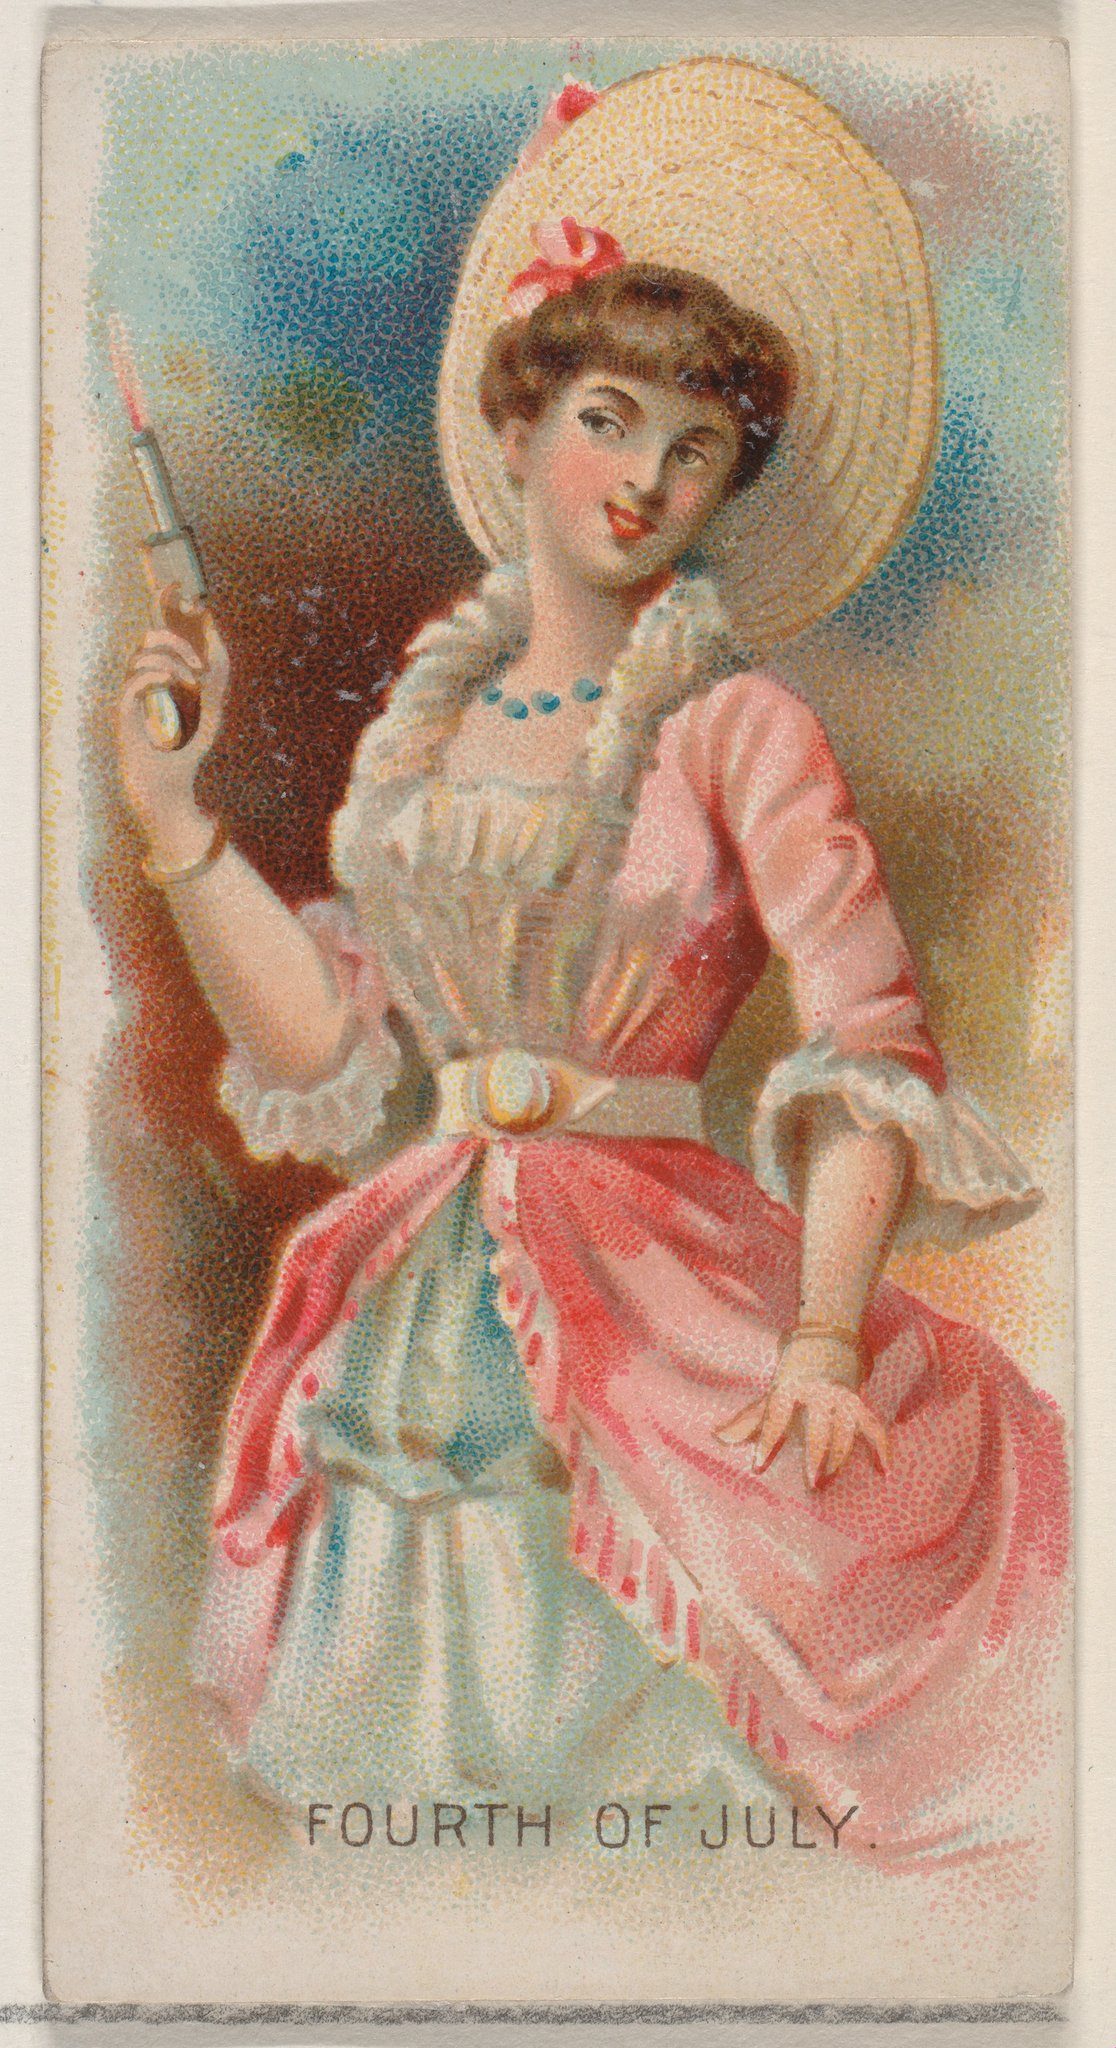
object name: print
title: Fourth of July, United States, from the Holidays series (N80) for Duke brand cigarettes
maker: w. duke, sons & co.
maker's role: publisher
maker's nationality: american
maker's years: 1870-1920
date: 1890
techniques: color lithograph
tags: women